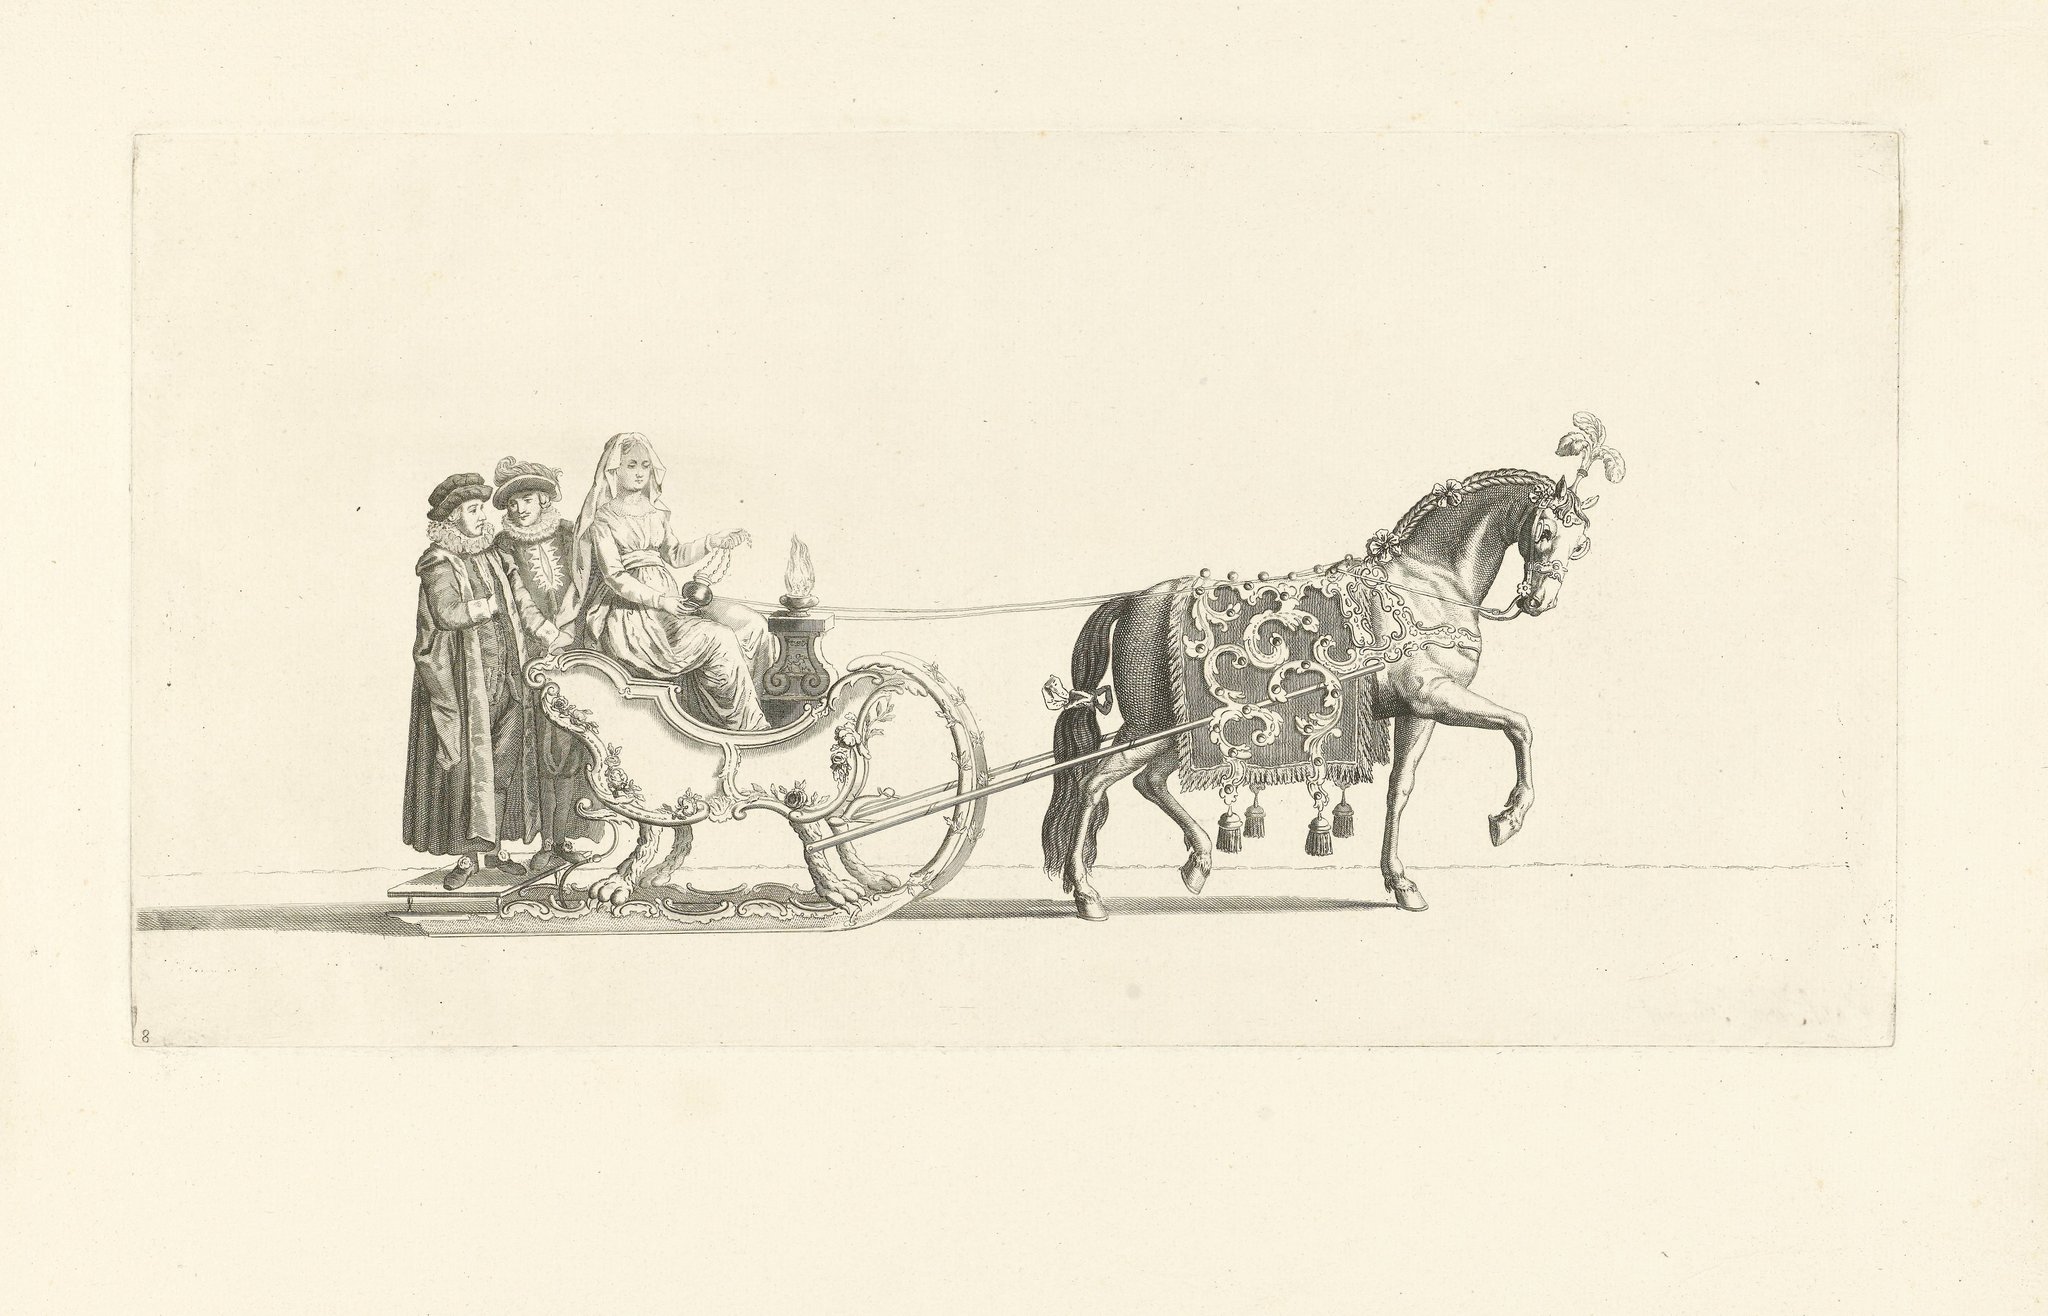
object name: print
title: Achtste slede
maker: nicolaas van der worm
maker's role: draughtsman, print maker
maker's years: 1757-1828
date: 1776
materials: paper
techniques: engraving, etching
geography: northern netherlands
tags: allegorical representations ~ religion; 'religione', 'religione de ss. mauritio e lazaro', 'religione vera christiana' (ripa), sledge, sleigh (winter sports), commemoration of the founding of a university, leiden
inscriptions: collector's mark: 2228, inscription: ‘Danl: Hendk: Righout’ Lugt Signatuur van Daniel Henricus Righout, de secretaris van het genootschap, als bewijs van echtheid.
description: De achtste slede in de optocht. Een slede met de personificatie van de Godsdienst, getrokken door een paard. Onderdeel van een reeks van twaalf platen van de sledevaart op 24 januari 1776 georganiseerd door het Leidse genootschap Veniam Pro Laude bij gelegenheid van het Tweede Eeuwfeest van het Leids Ontzet (3 oktober 1574) en de oprichting van de Universiteit van Leiden (8 februari 1575).